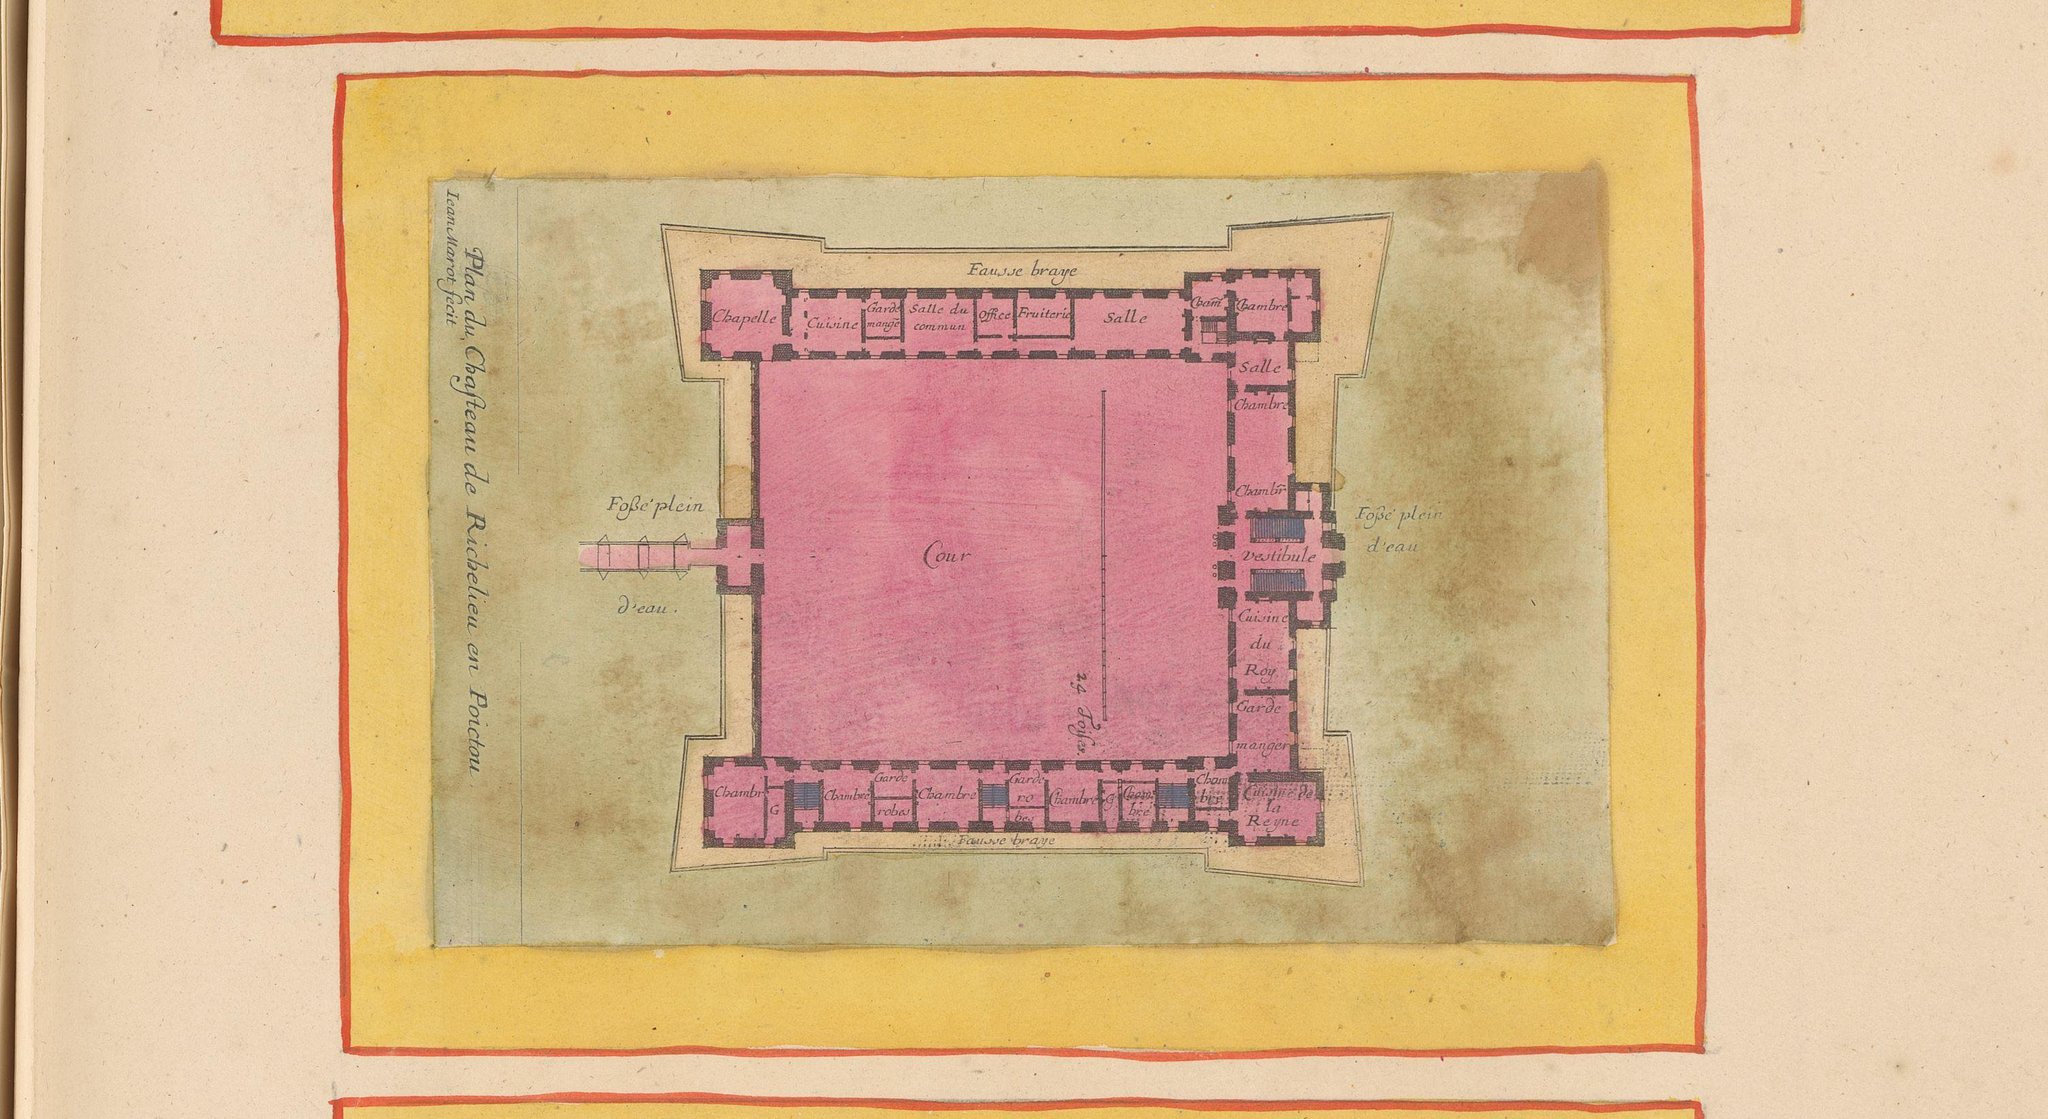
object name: album leaf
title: Plan du chasteau de Richelieu en Poictou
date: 1629-1679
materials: paper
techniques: etching, hand coloring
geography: the hague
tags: plan ~ architecture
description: Deze prent maakt deel uit van een album.